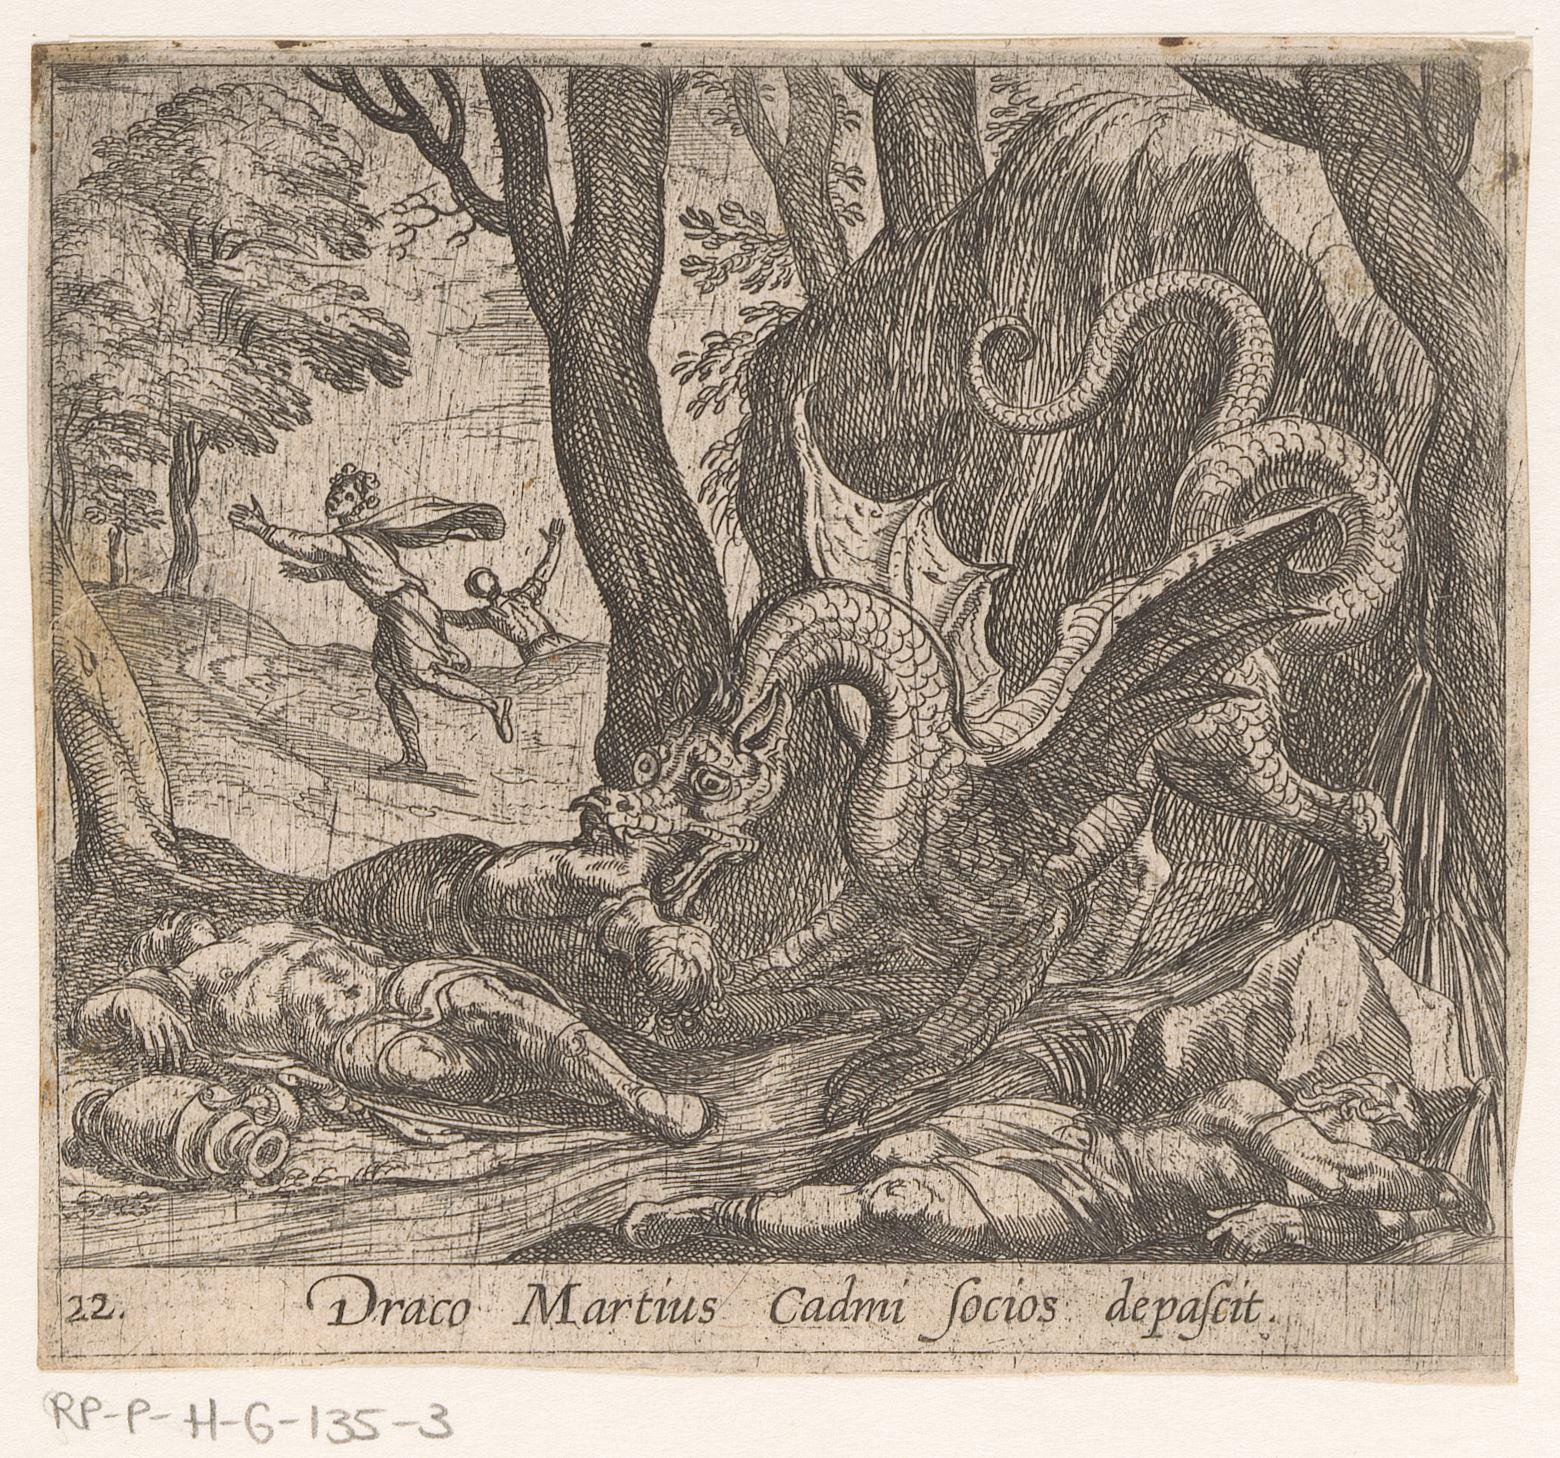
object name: print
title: Metamorfosen van Ovidius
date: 1606-1638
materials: paper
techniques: etching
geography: italy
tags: cadmus' companions, sent to fetch water, are slain by the dragon which guarded the spring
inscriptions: collector's mark: ‘Hinloopen’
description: Deze prent maakt deel uit van een reeks van 150 prenten (+ titelprent) met voorstellingen van de Metamorfosen van Ovidius.